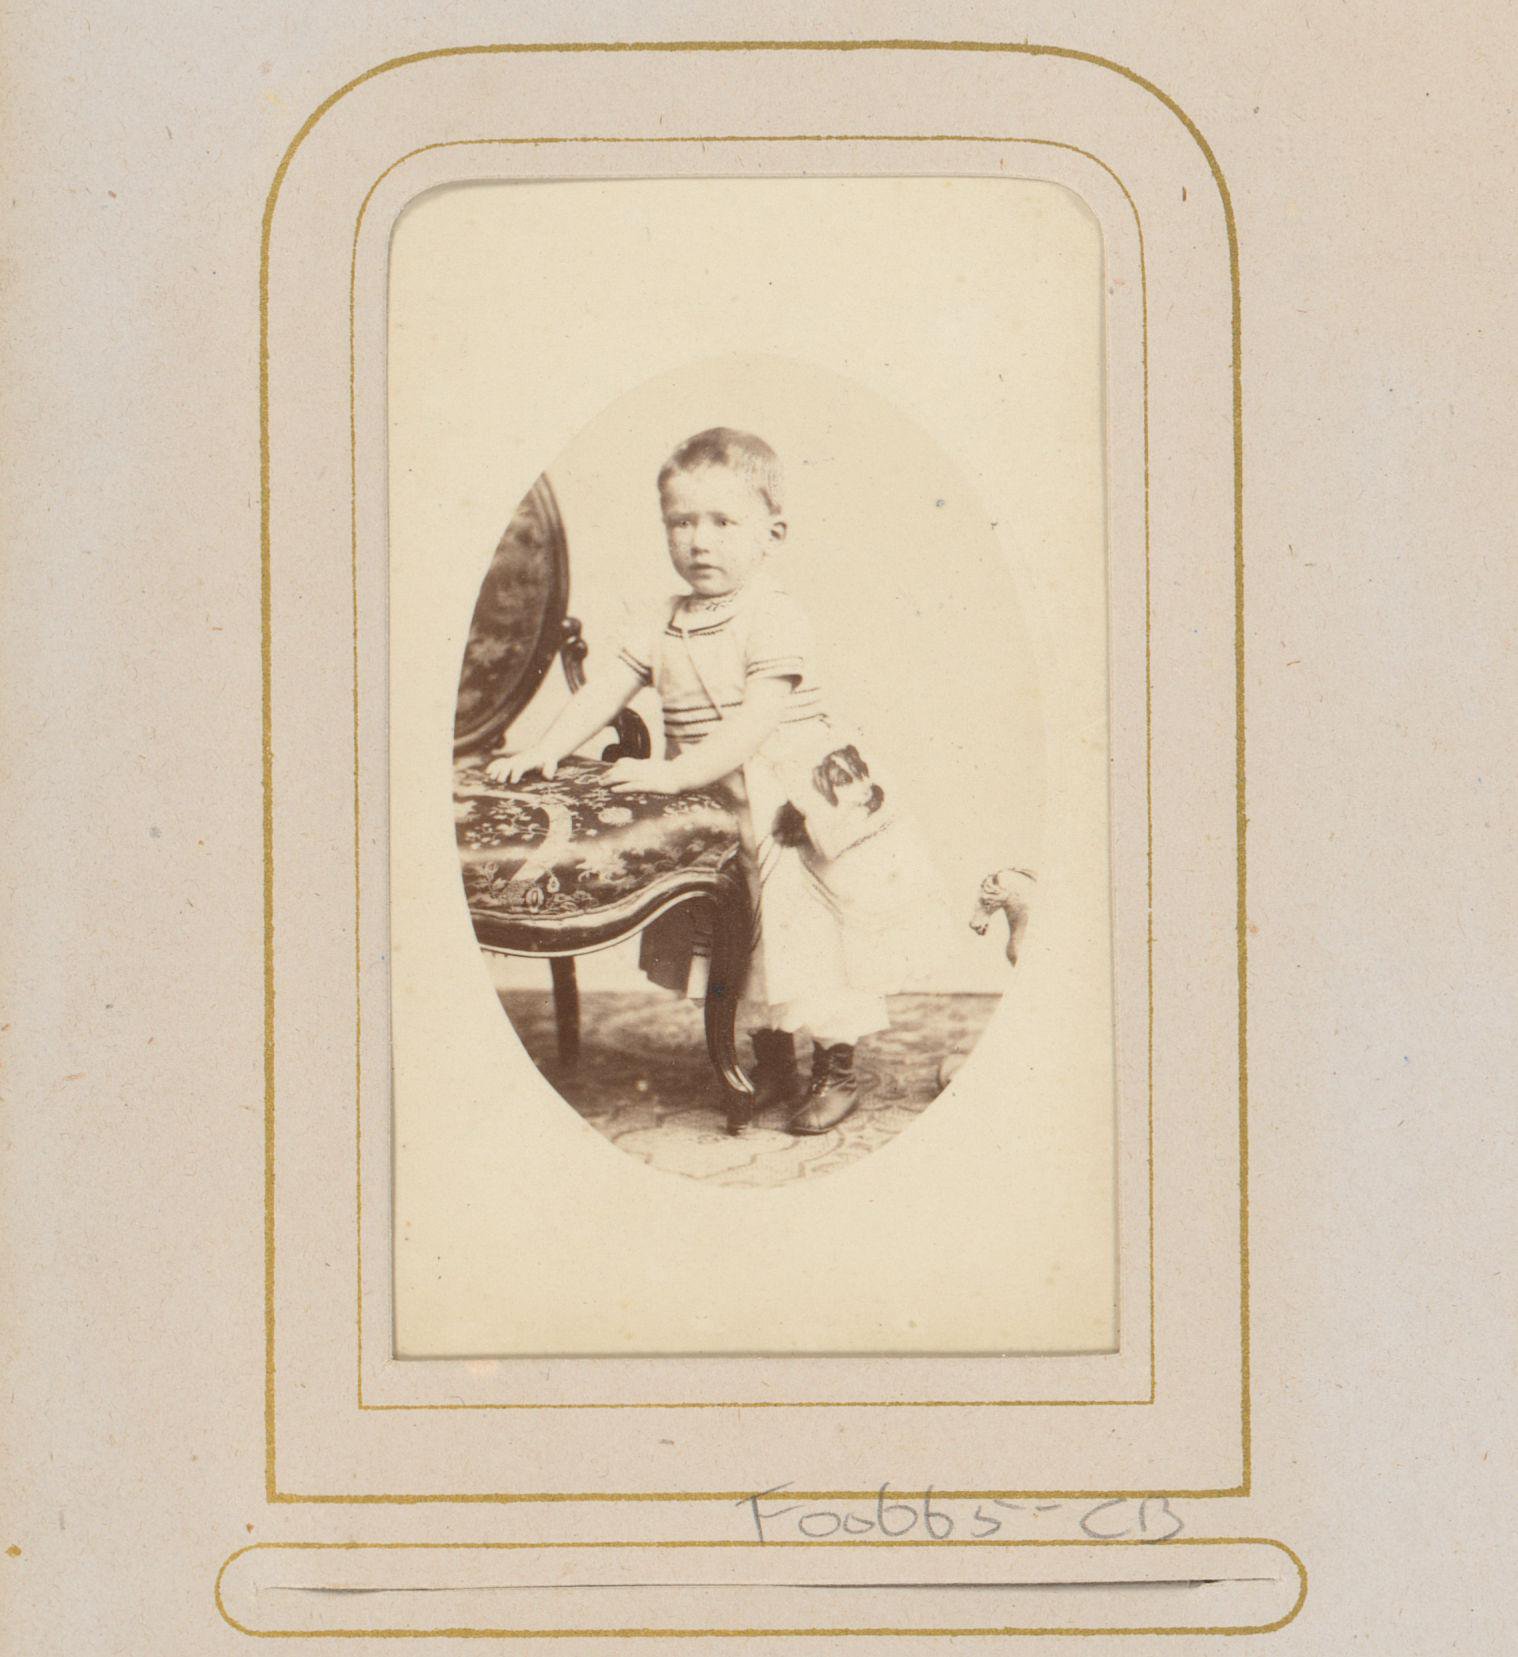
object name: photograph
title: Portret van een jongen met tas en speelgoedpaard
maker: johannes ephraim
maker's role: fotograaf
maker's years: 1838-1921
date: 1867-1890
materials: cardboard, photographic support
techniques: albumen print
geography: arnhem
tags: boy (child between toddler and youth)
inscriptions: inscription: ‘Photogr. Atelier/ J. Ephraim, Jr./ Rynkade, 311 & 312/ Arnhem’